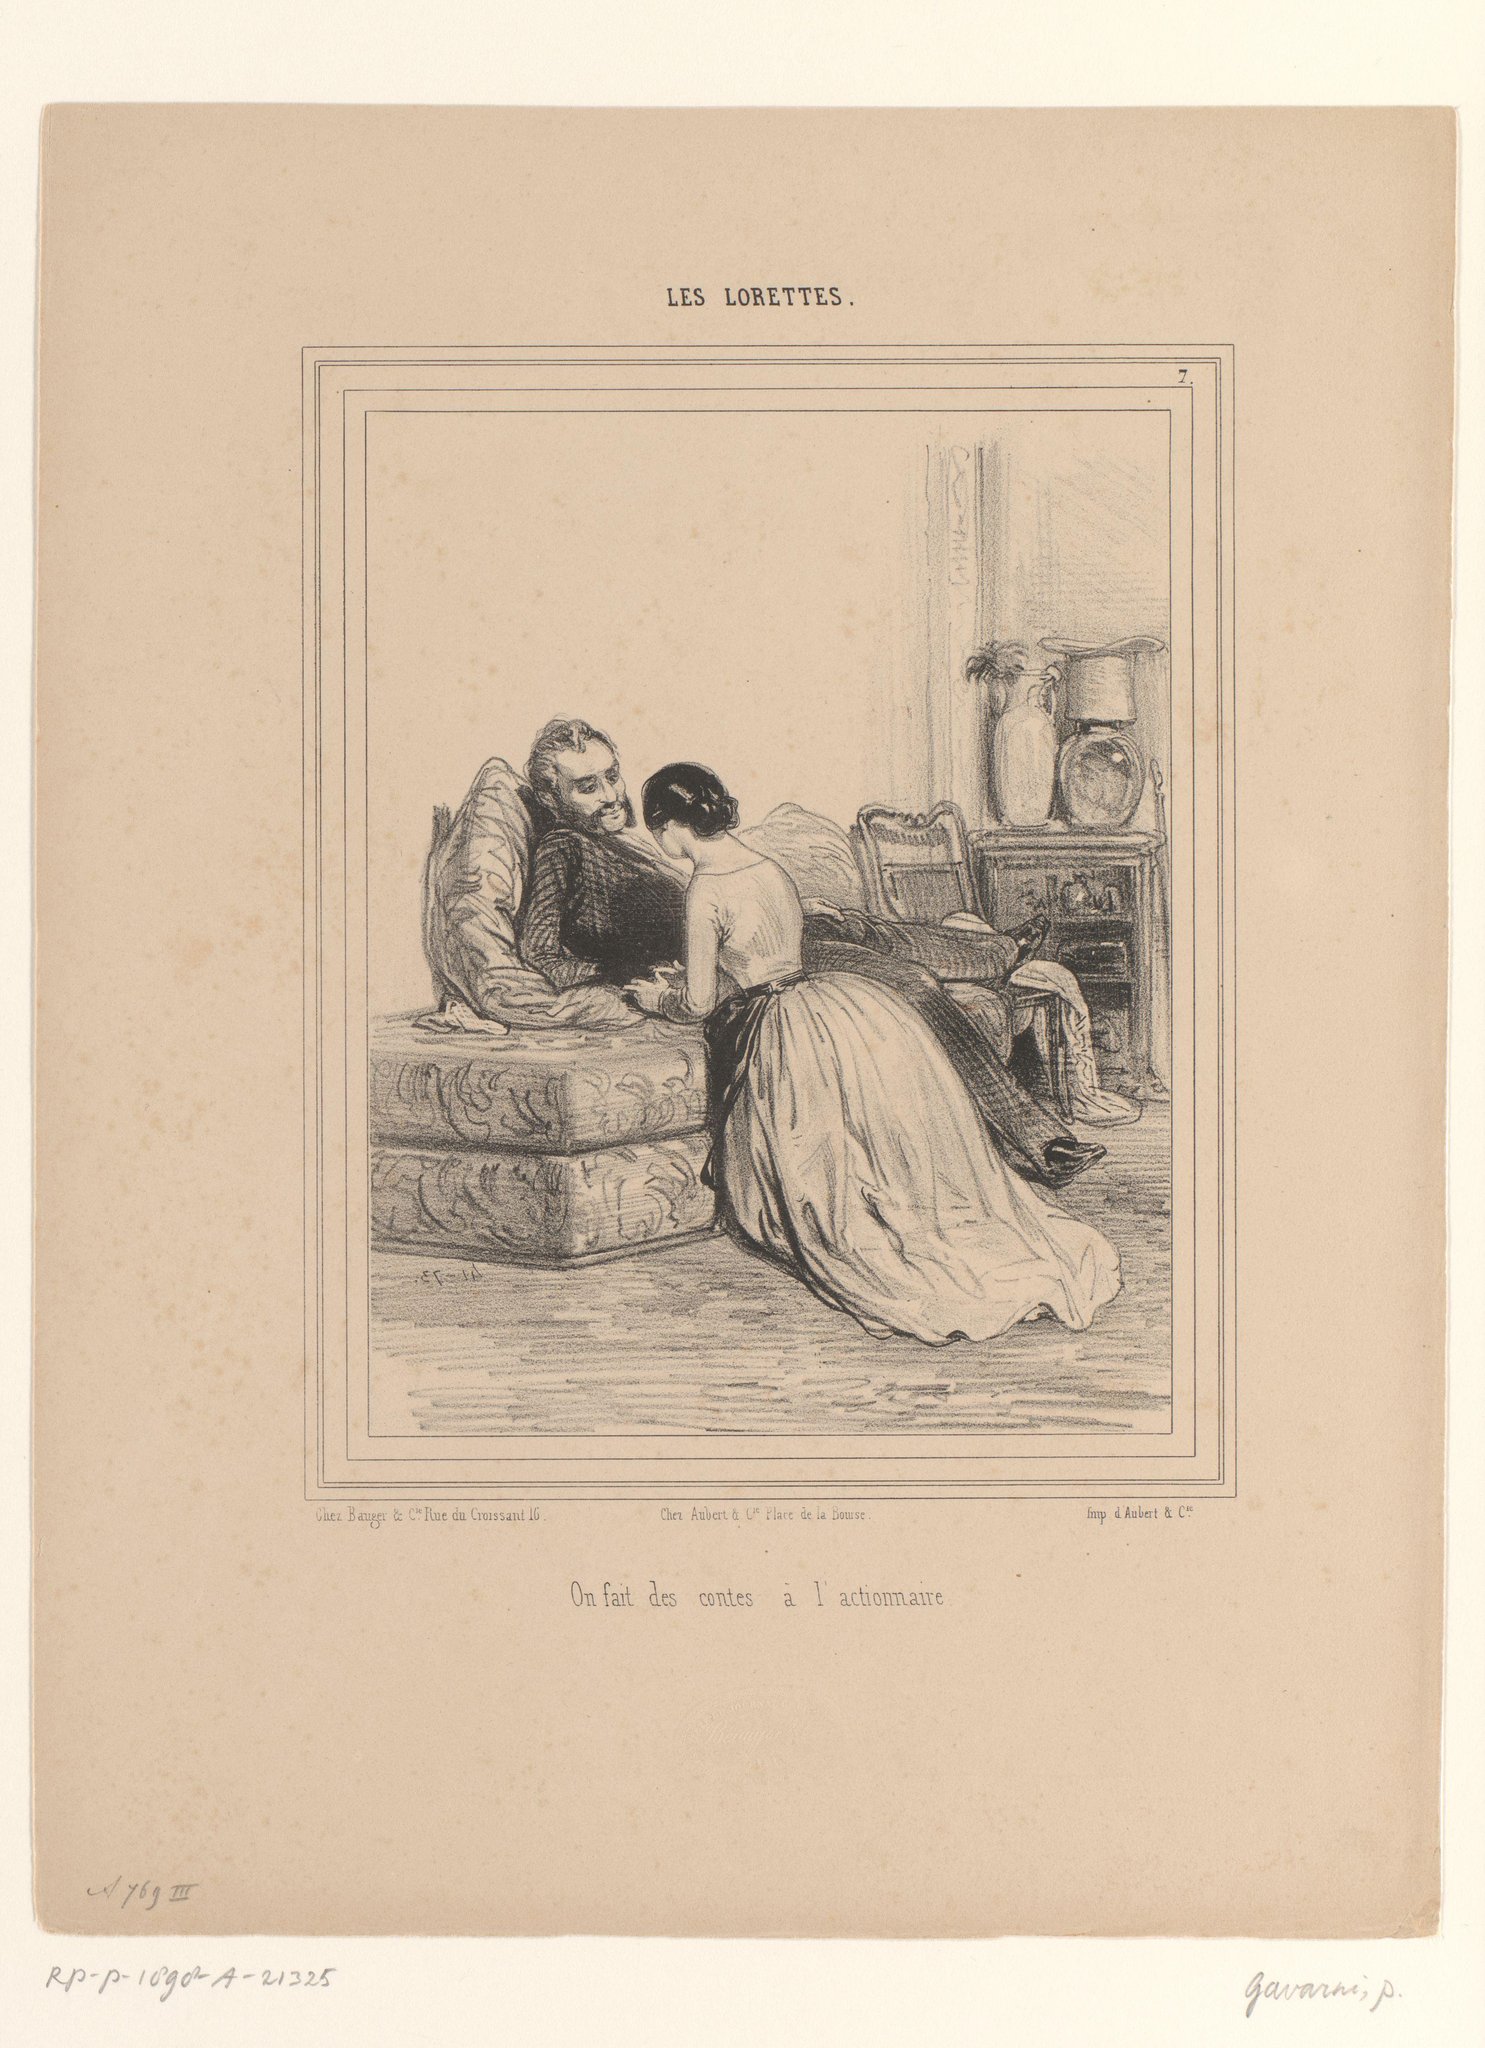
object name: print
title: On fait des contes à l'actionnaire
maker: paul gavarni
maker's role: draughtsman, print maker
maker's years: 1804-1866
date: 1841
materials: paper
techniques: lithograph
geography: paris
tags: marriage, married couple, 'matrimonium', couch, sofa, settee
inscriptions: check stamp: Lugt 3855, collector's mark: Lugt 964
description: Prent gebruikt voor: Le Charivari, 7 oktober 1841.